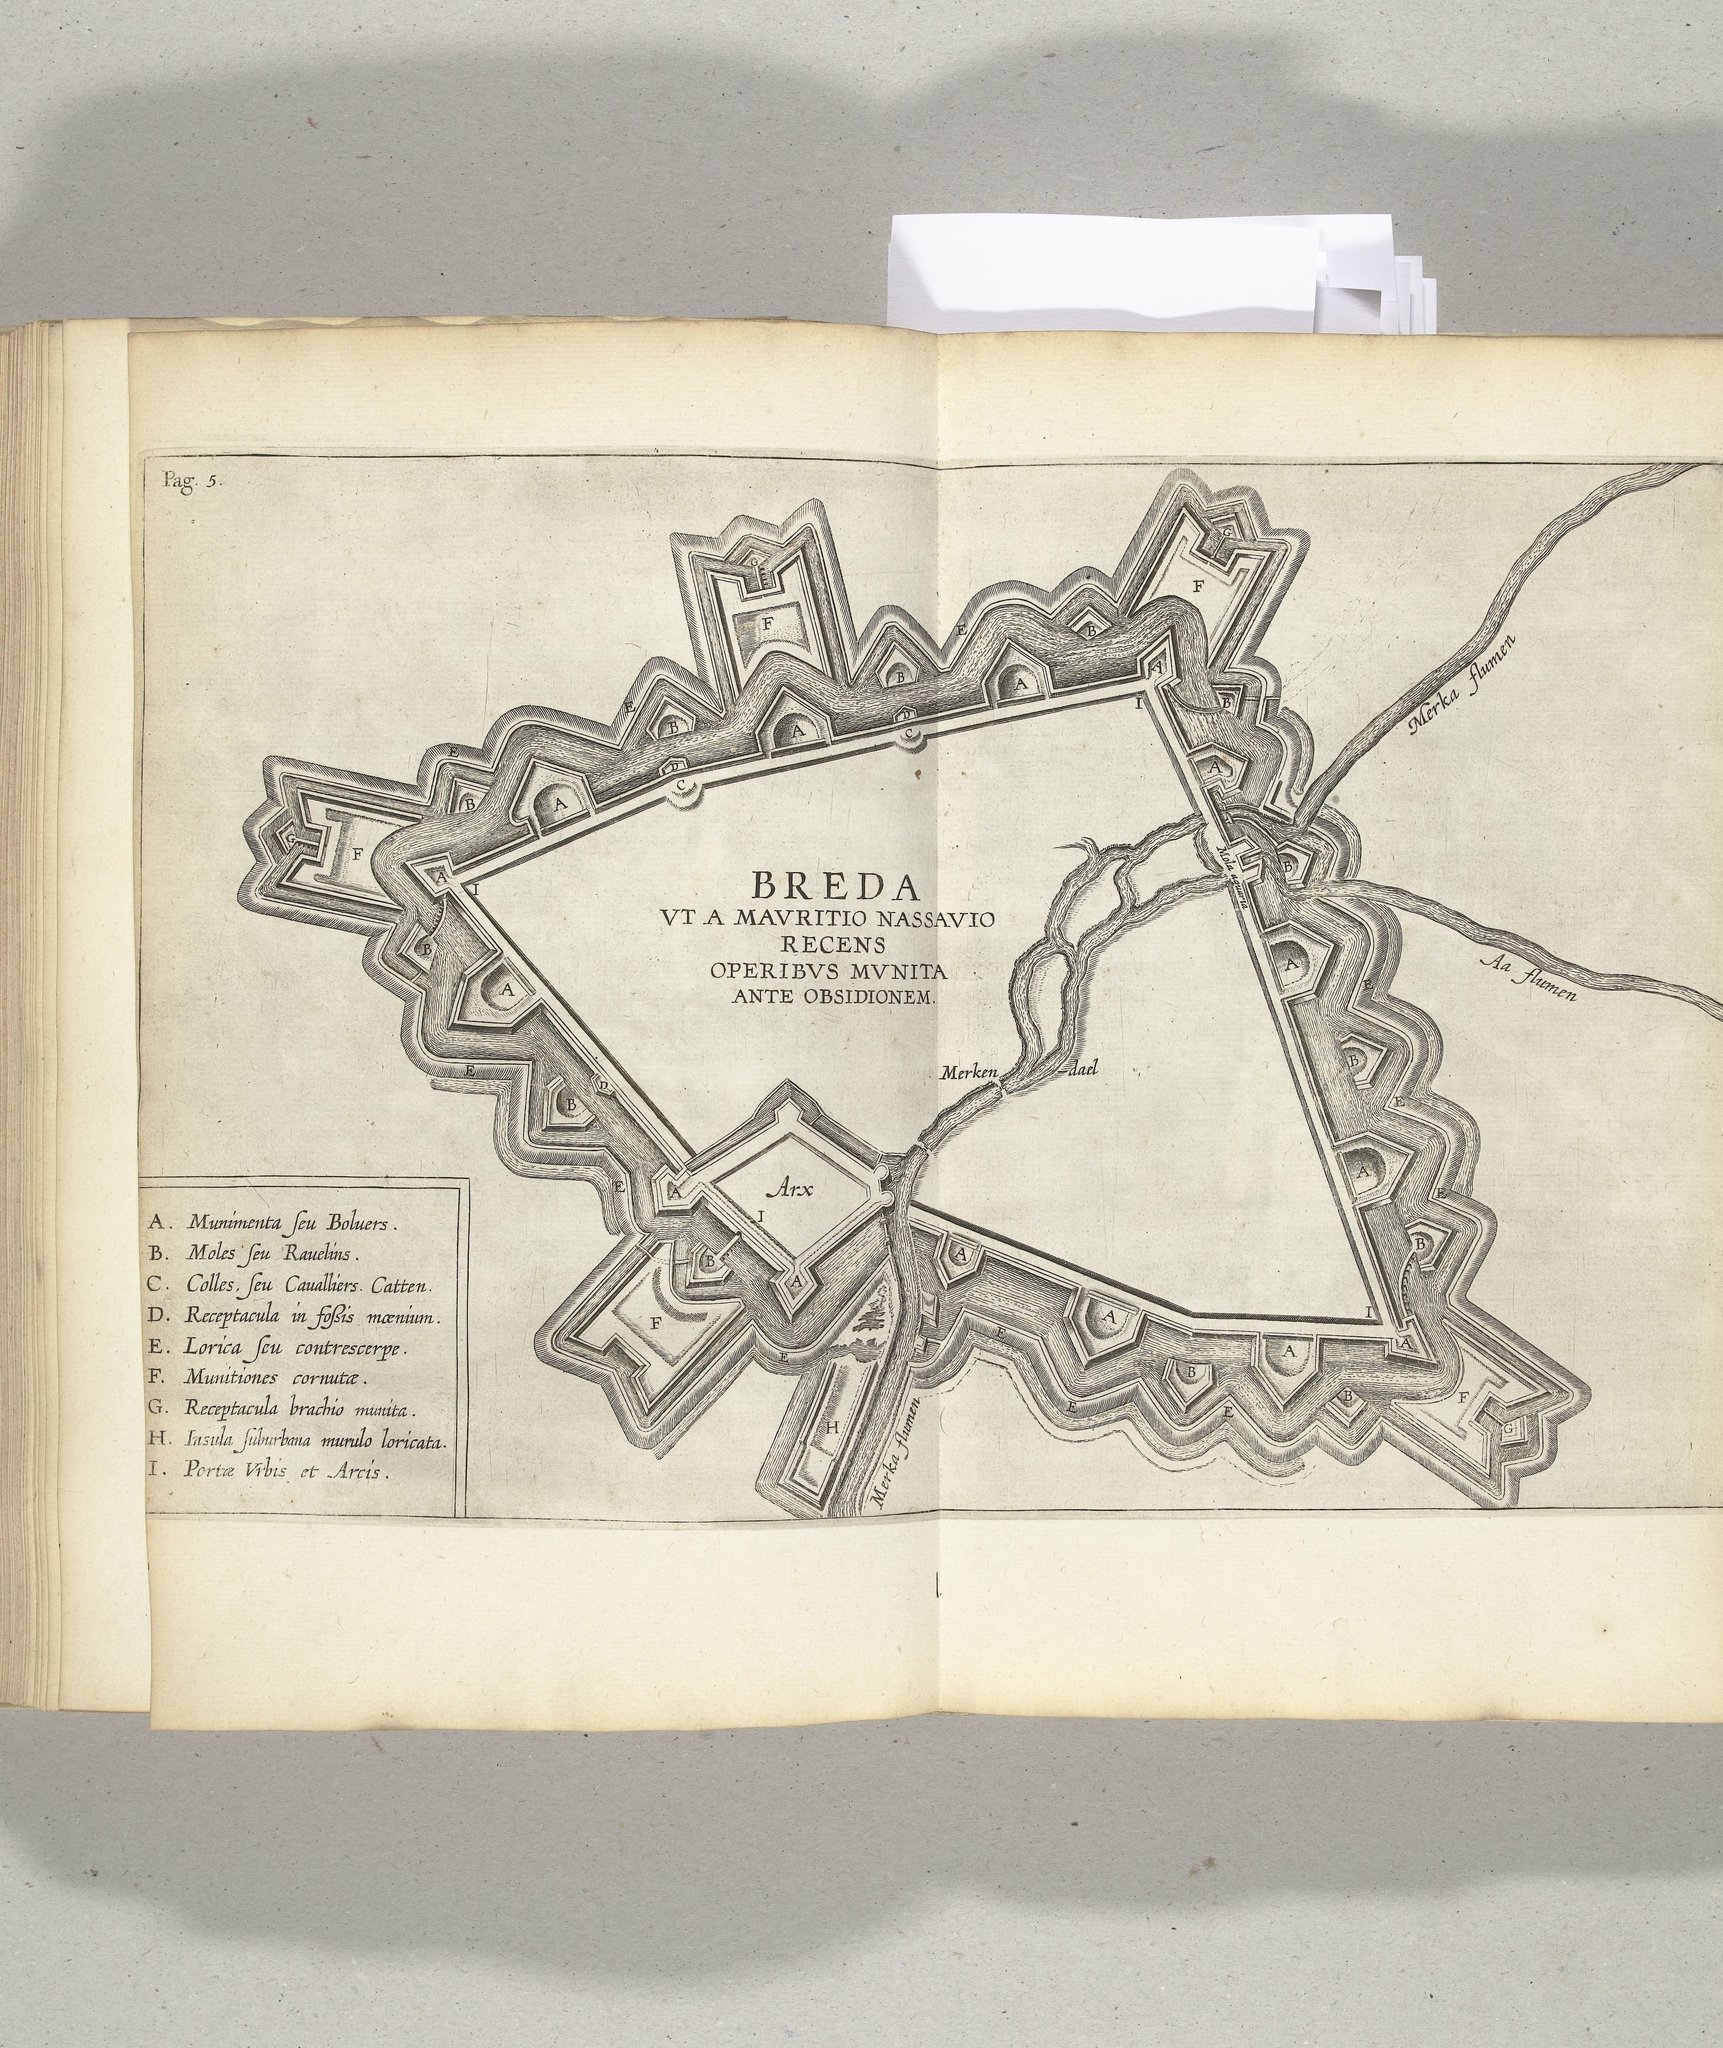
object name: print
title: Breda ut a Mauritio Nassauio recens operibus munita ante obsionem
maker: Anonymous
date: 1625-1626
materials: paper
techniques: etching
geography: southern netherlands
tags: fortifications, military engineering, maps of cities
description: Illustratie in: Hermannus Hugo, Obsidio Bredana armis Philippi IIII avspiciis Isabellae Dvctv Ambr. Spinolae perfecta, ex off. Plantiniana, Antwerpen 1629, p. 4/5. Exemplaar in de collectie van de Rijksmuseum Research Library met signatuur 327 I 25. In M. Funck, Le livre belge à gravures : guide de l'amateur de livres illustrés imprimés en Belgique avant le XVIIIe siècle (1925) worden deze illustraties toegeschreven aan Theodoor Galle (11) en Schelte en Boëtius Bolswert (4). Ze worden echter in Hollstein niet bij deze prentmakers vermeld.